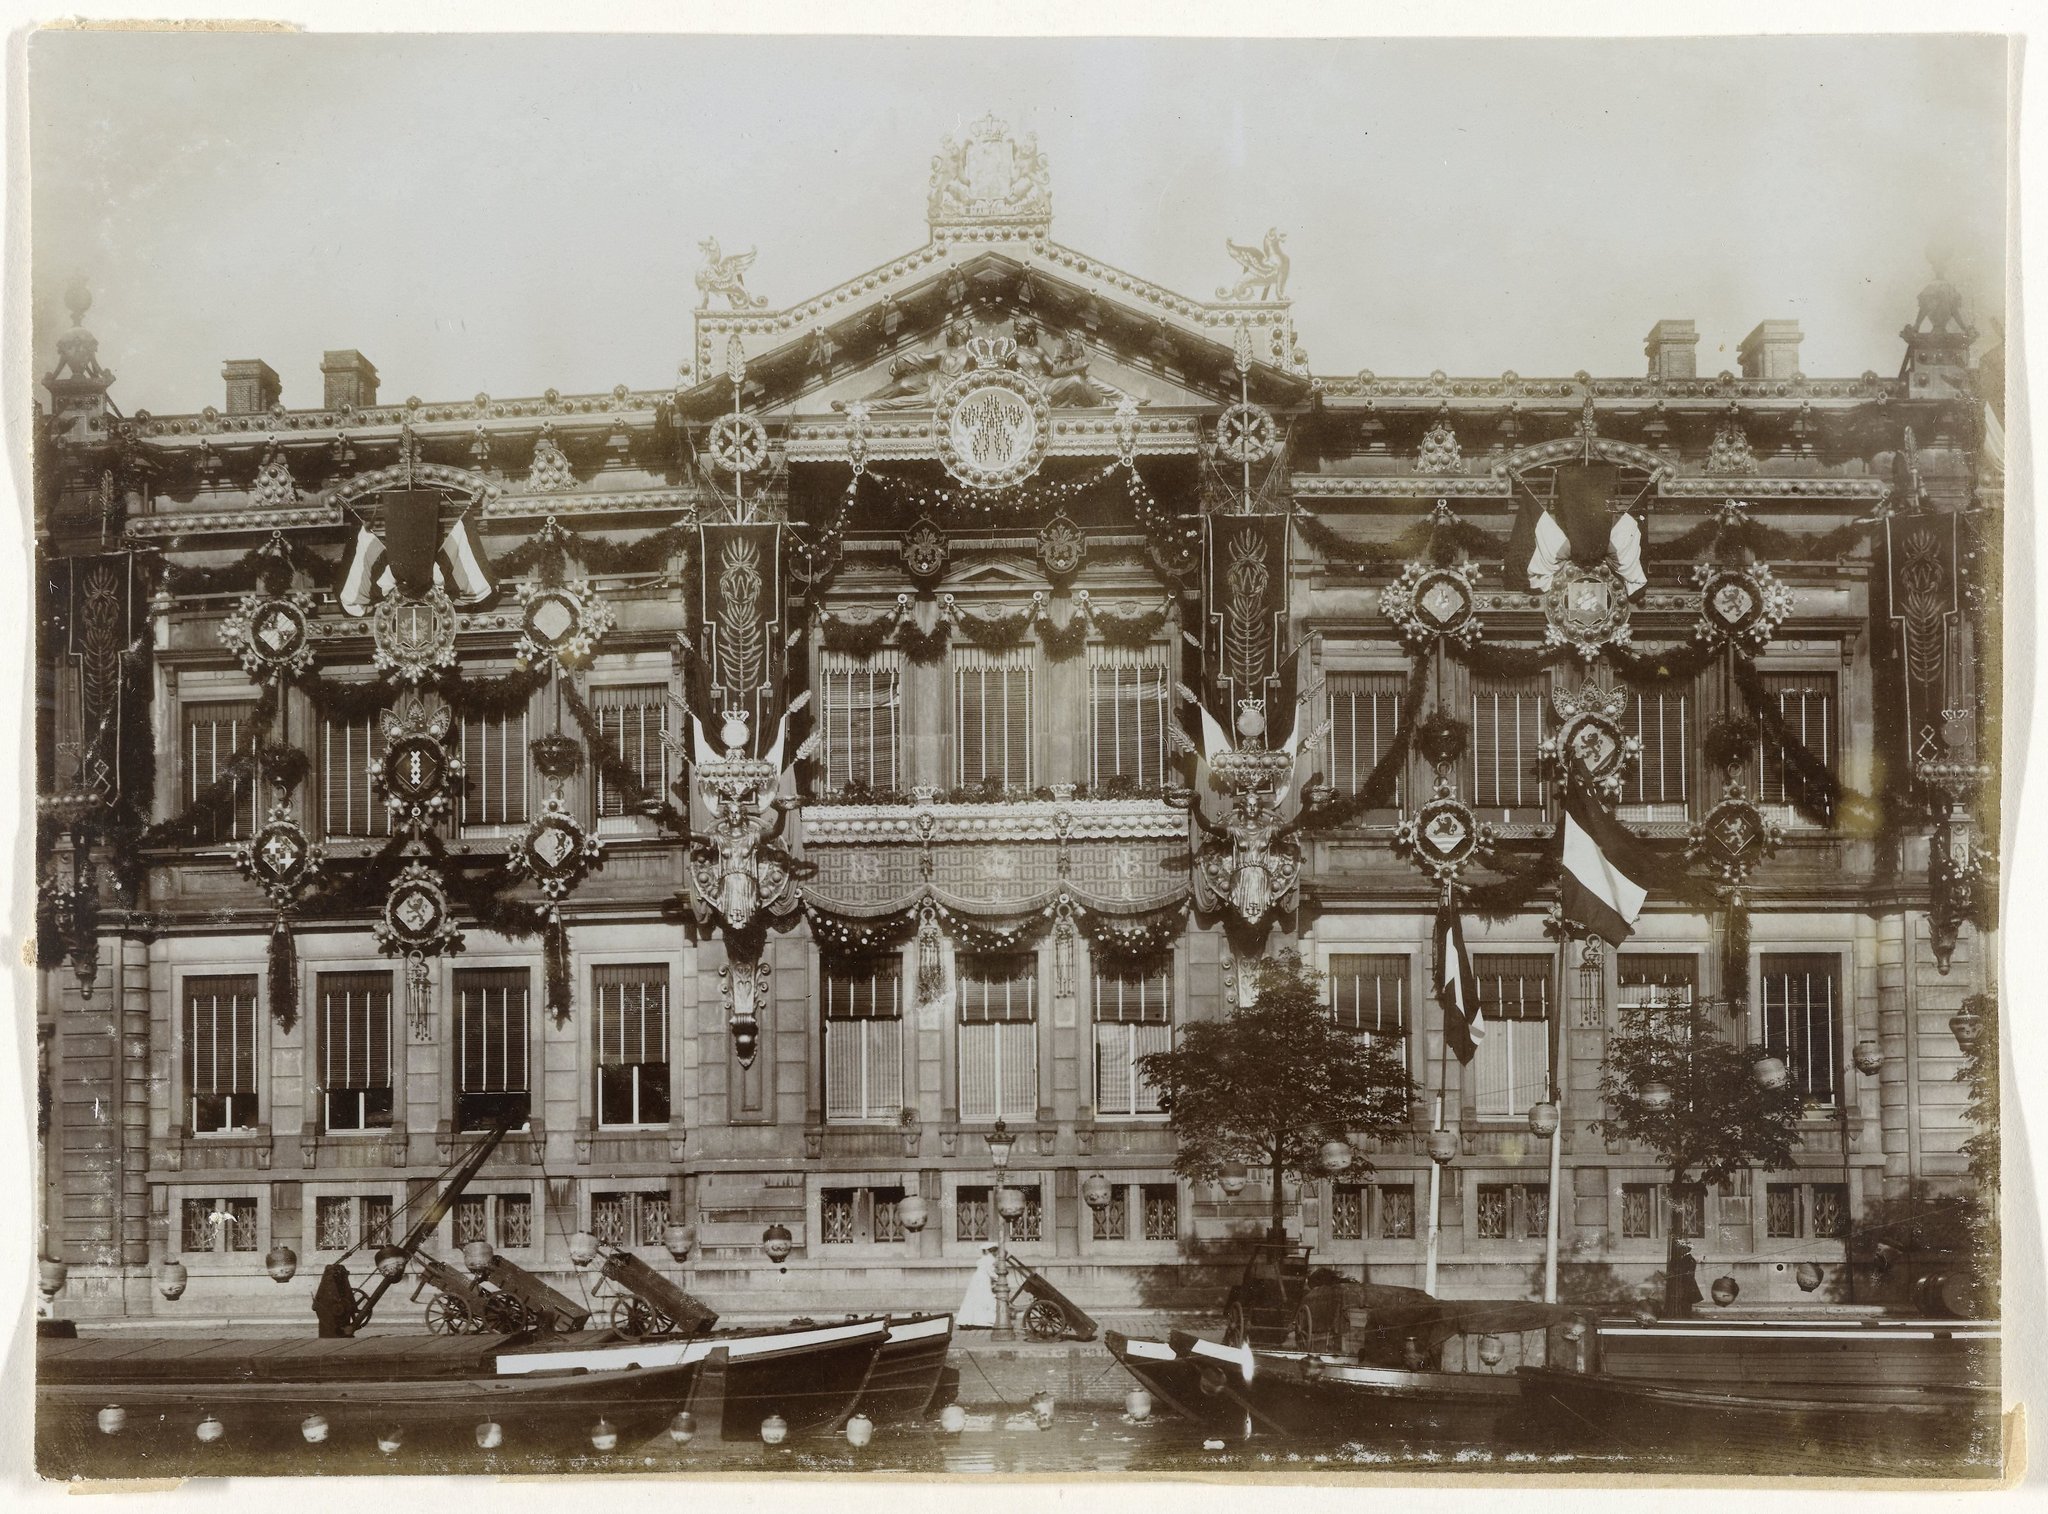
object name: photograph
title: Gezicht op de Nederlandsche Bank aan de Oude Turfmarkt 127, versierd ter gelegenheid van de inhuldiging van koningin Wilhelmina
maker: Anonymous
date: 1809-1898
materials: paper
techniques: collodion silver print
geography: amsterdam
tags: bank